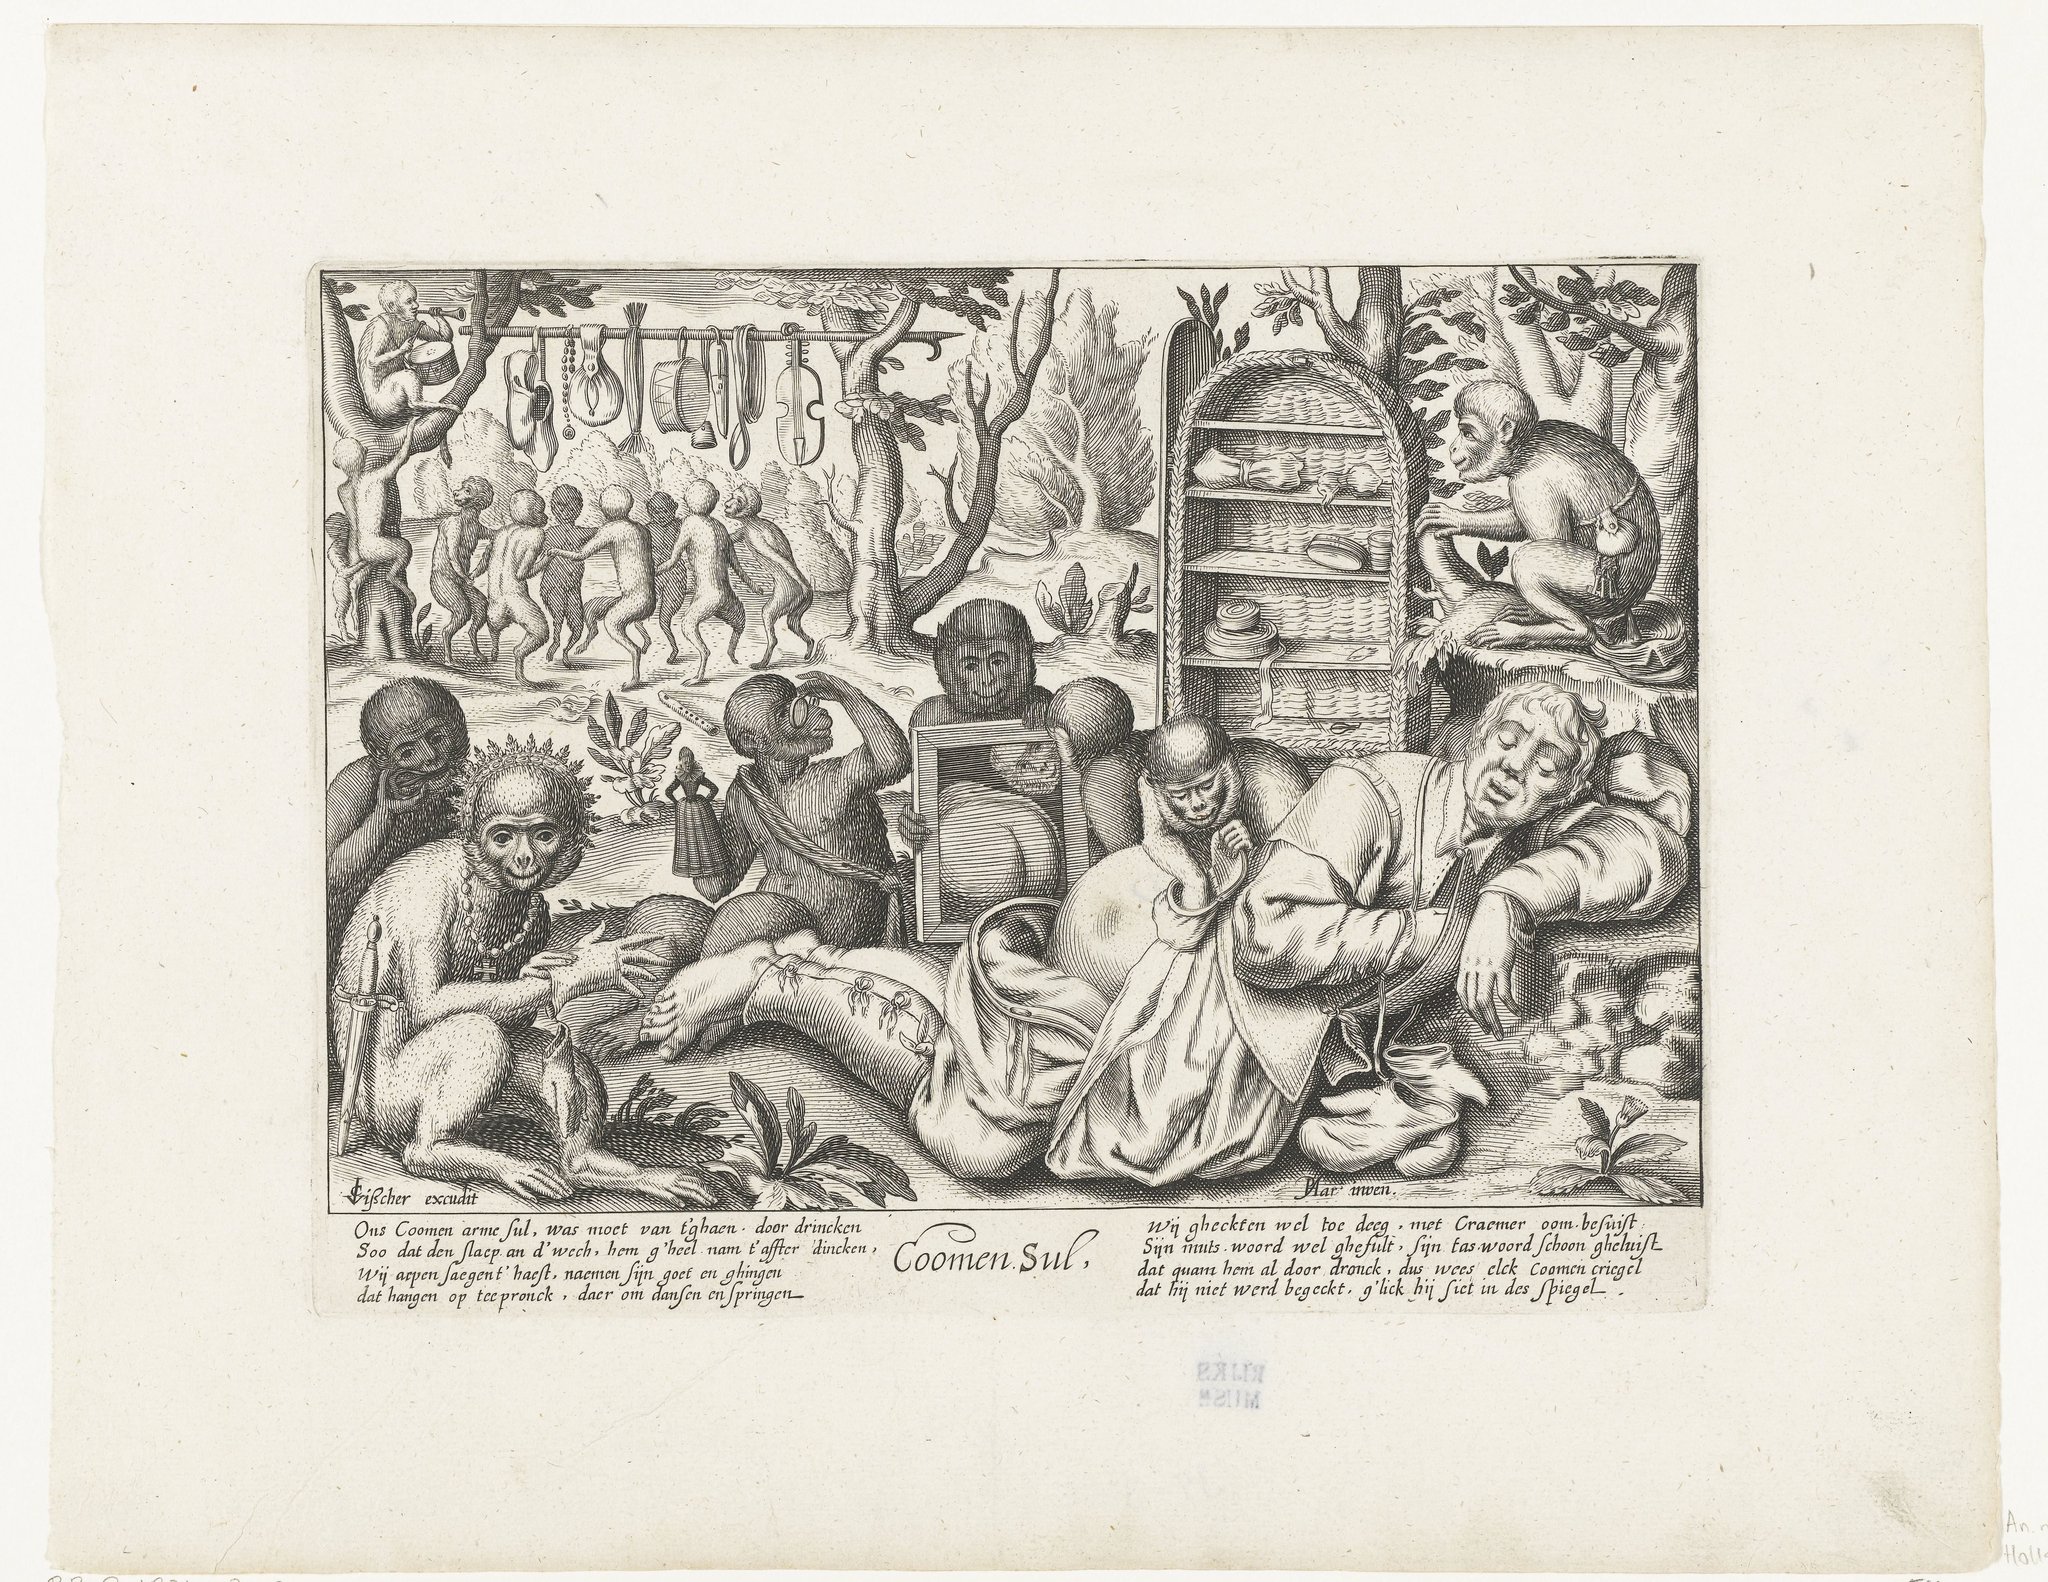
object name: print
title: De slapende koopman en de apen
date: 1600-1650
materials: paper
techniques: engraving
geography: low countries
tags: monkeys, apes, pedlar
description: Een slapende koopman wordt beroofd en bespot door apen. Enkele apen hebben stukken van zijn koopwaar aangetrokken. Apen hebben zijn broek losgemaakt waardoor zijn achterwerk in een spiegel te zien is, een andere aap poept in zijn hoed. Op de achtergrond een groep van dansende apen met muziekinstrumenten. Met onderschrift van 8 regels in het Nederlands.